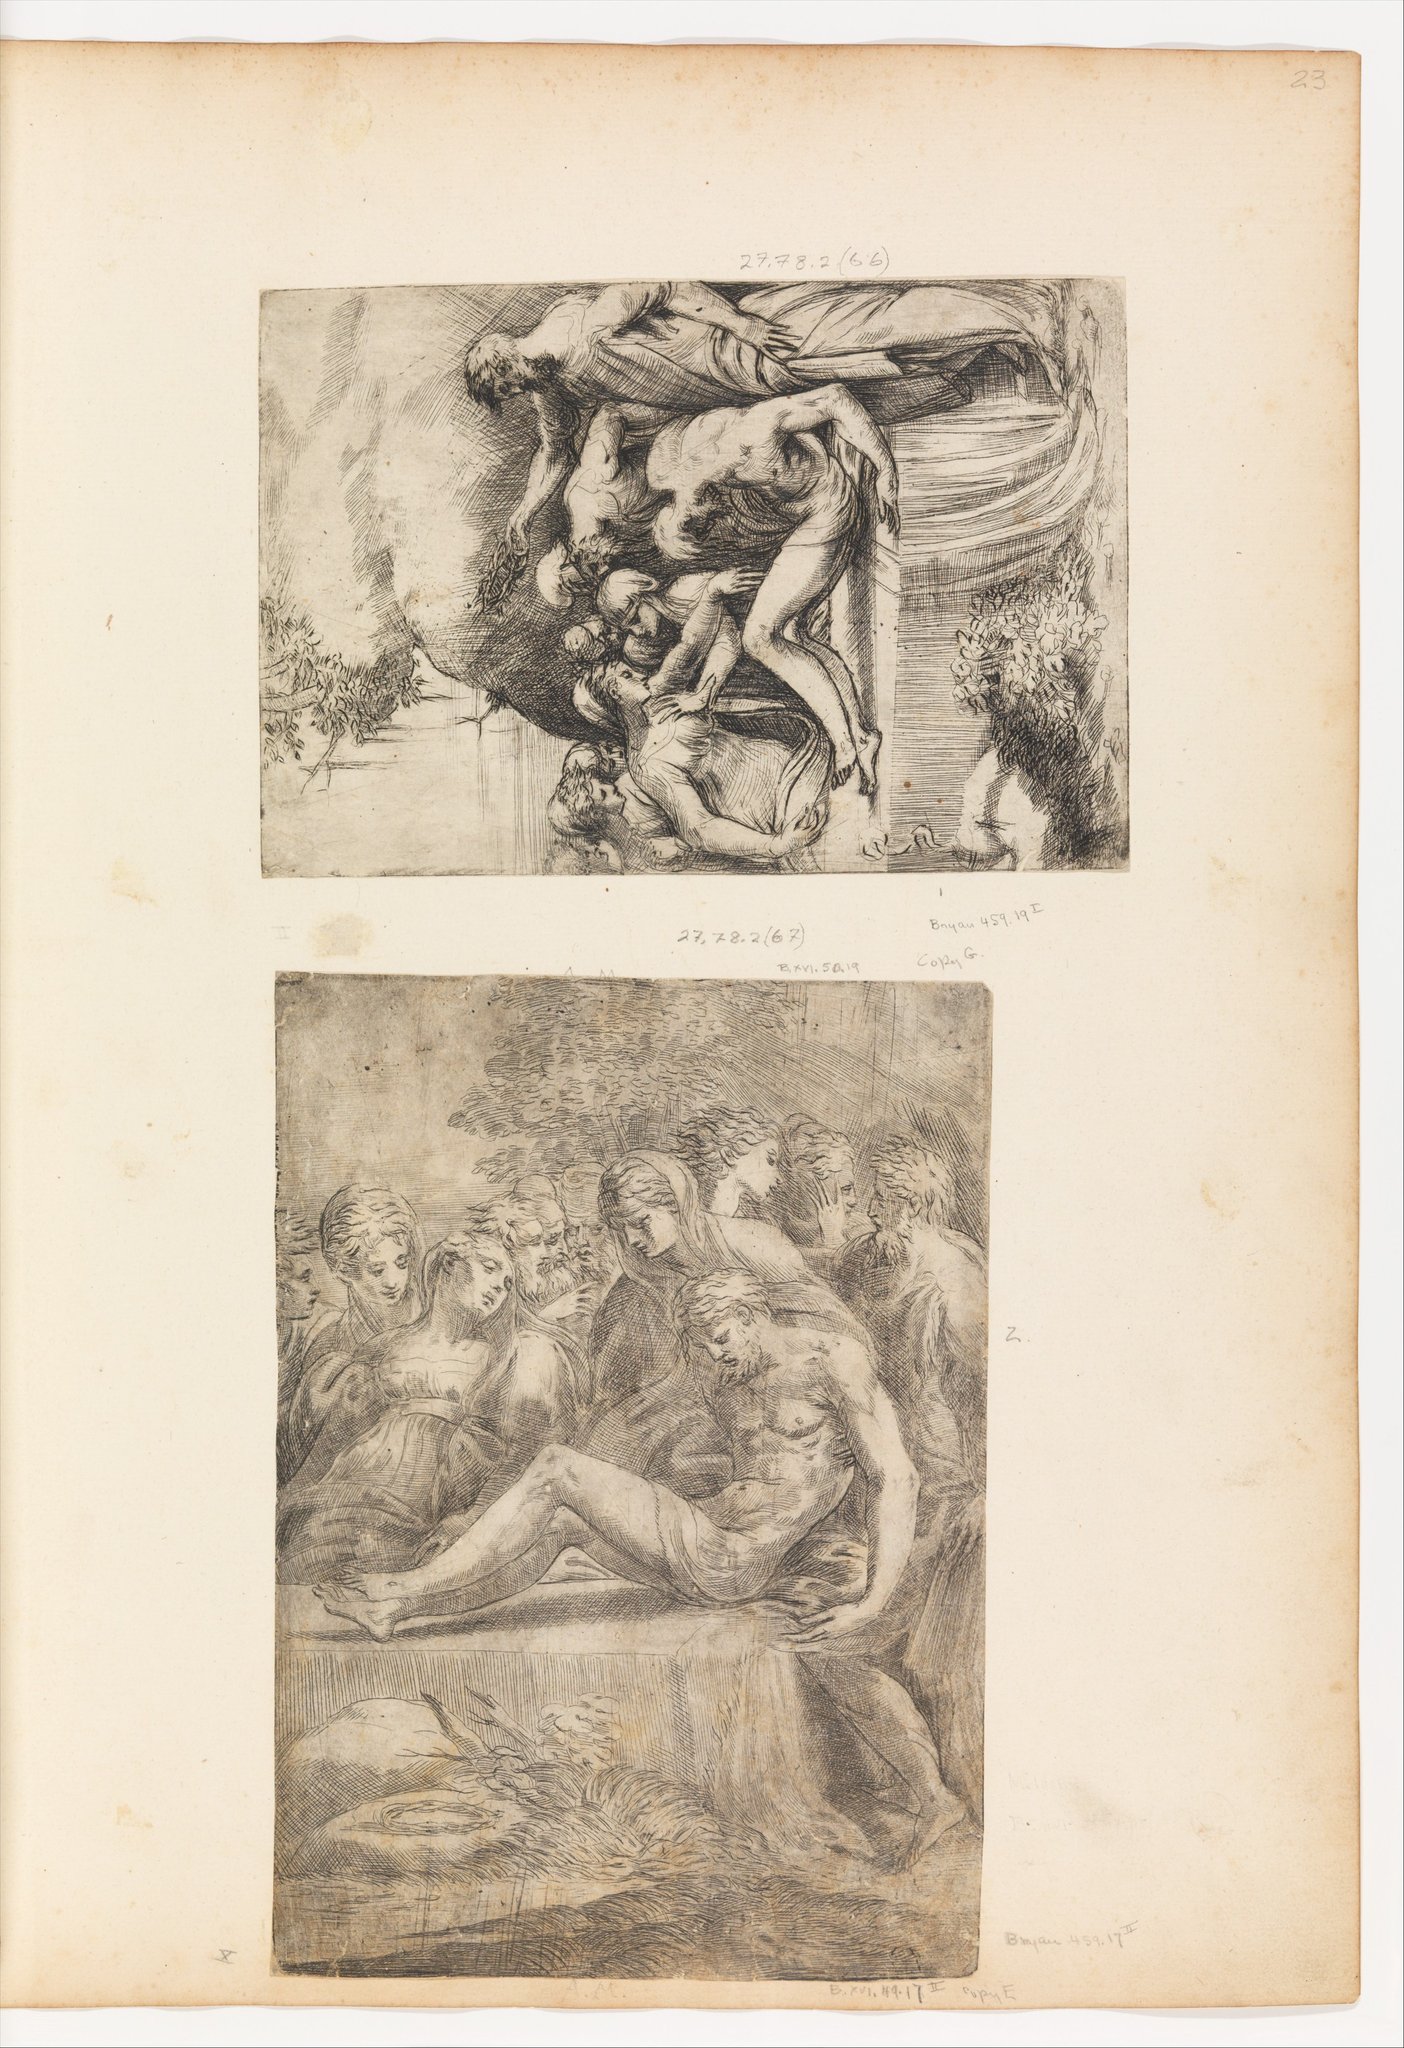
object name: print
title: The Lamentation over the Dead Christ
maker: andrea schiavone (andrea meldola)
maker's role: artist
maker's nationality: italian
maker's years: 1510-1563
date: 1540-1545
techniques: drypoint, etching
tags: christ,lamentation